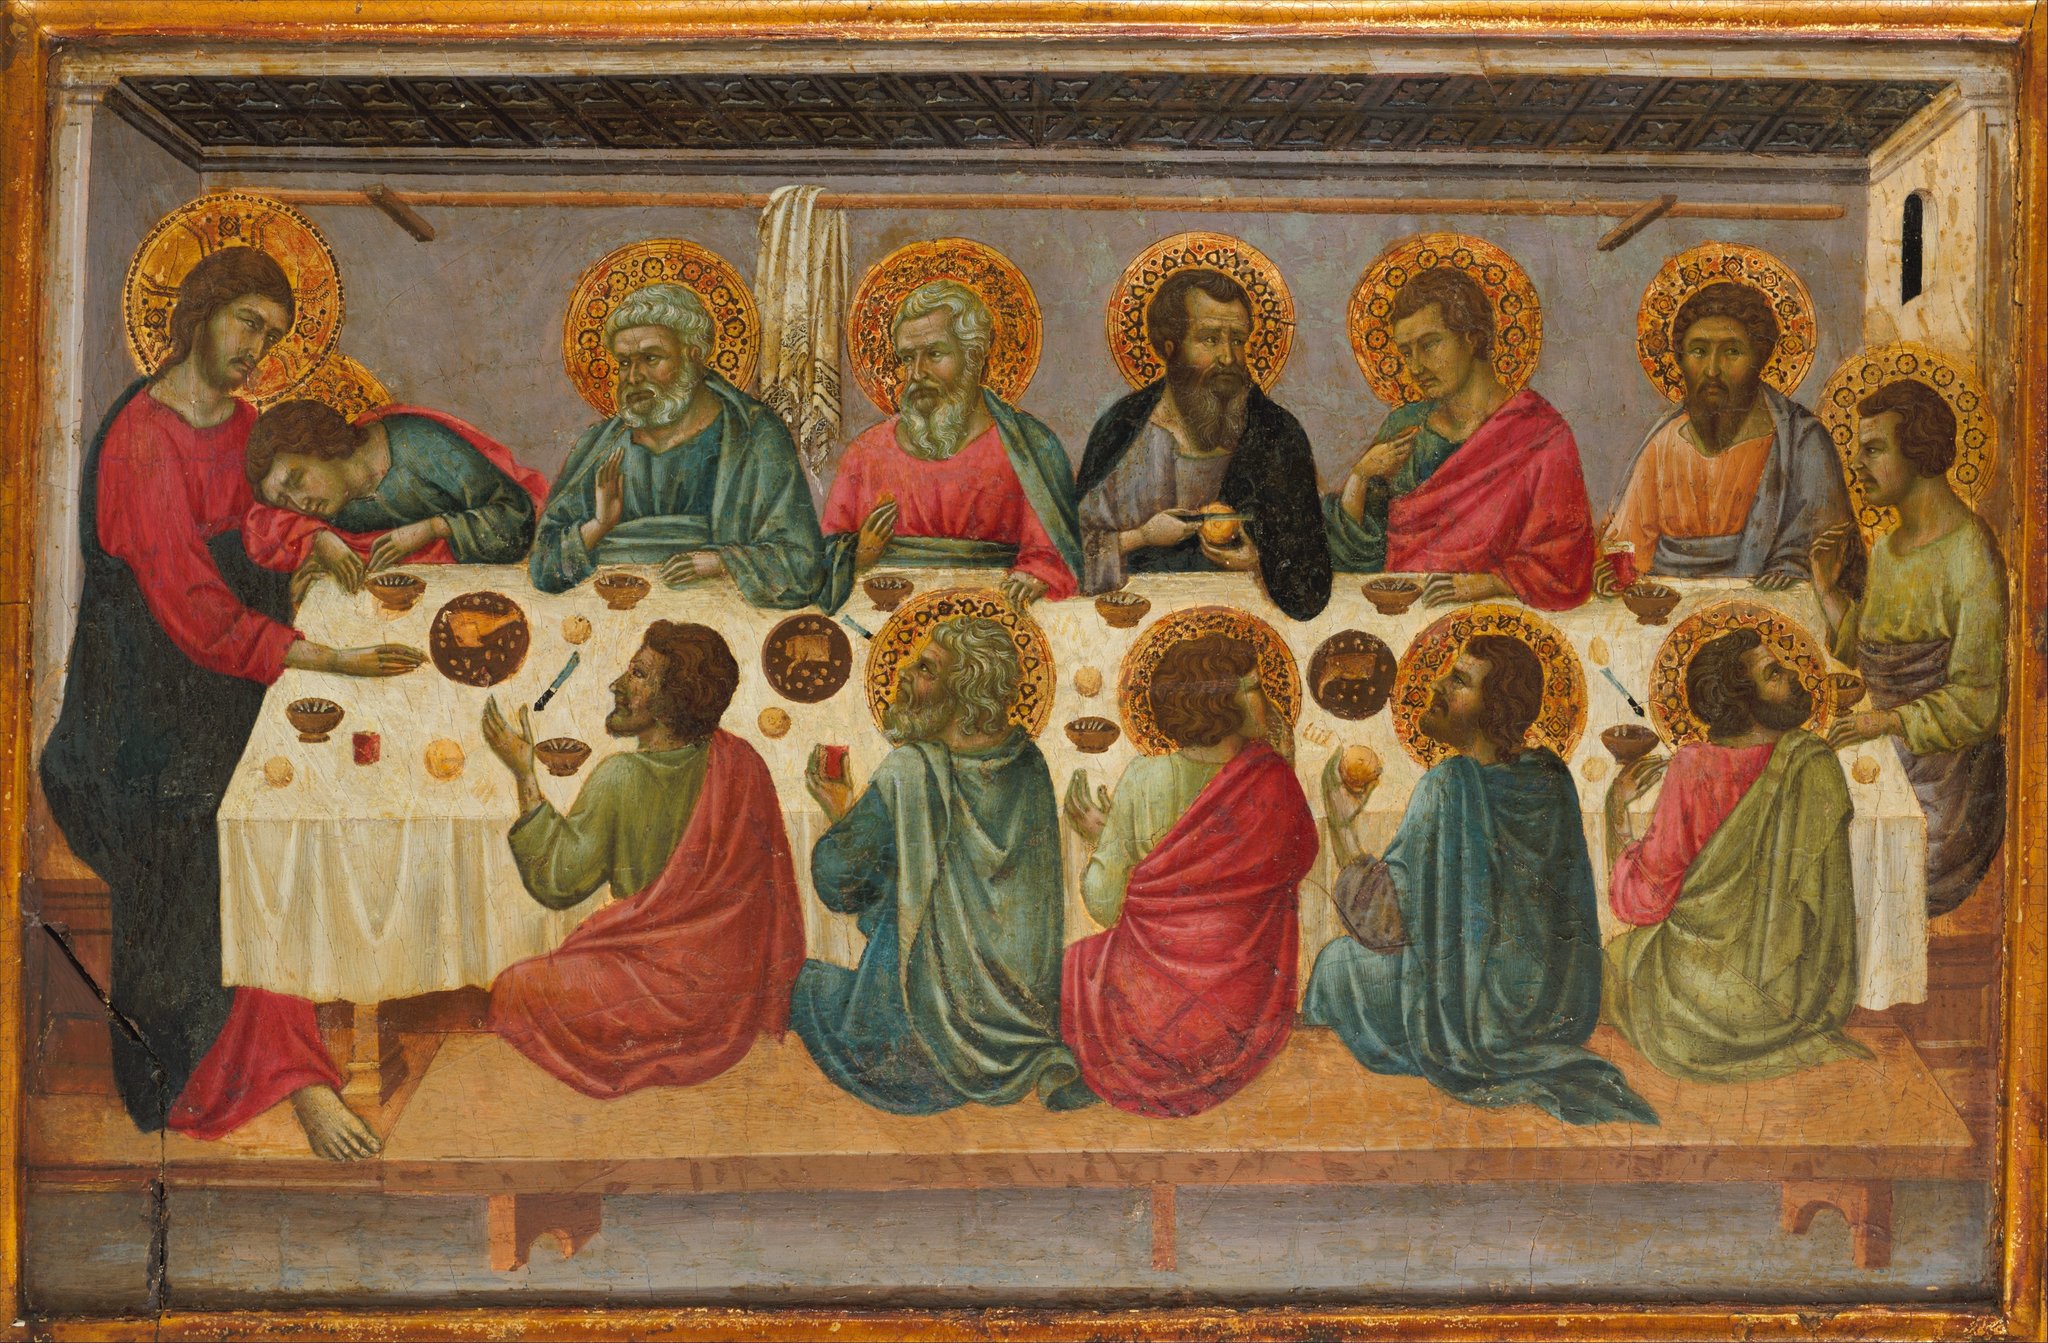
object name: painting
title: The Last Supper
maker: ugolino da siena (ugolino di nerio)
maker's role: artist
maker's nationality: italian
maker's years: 1317-1349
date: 1325-1330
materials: gold, paint, wood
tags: men,last supper,saints